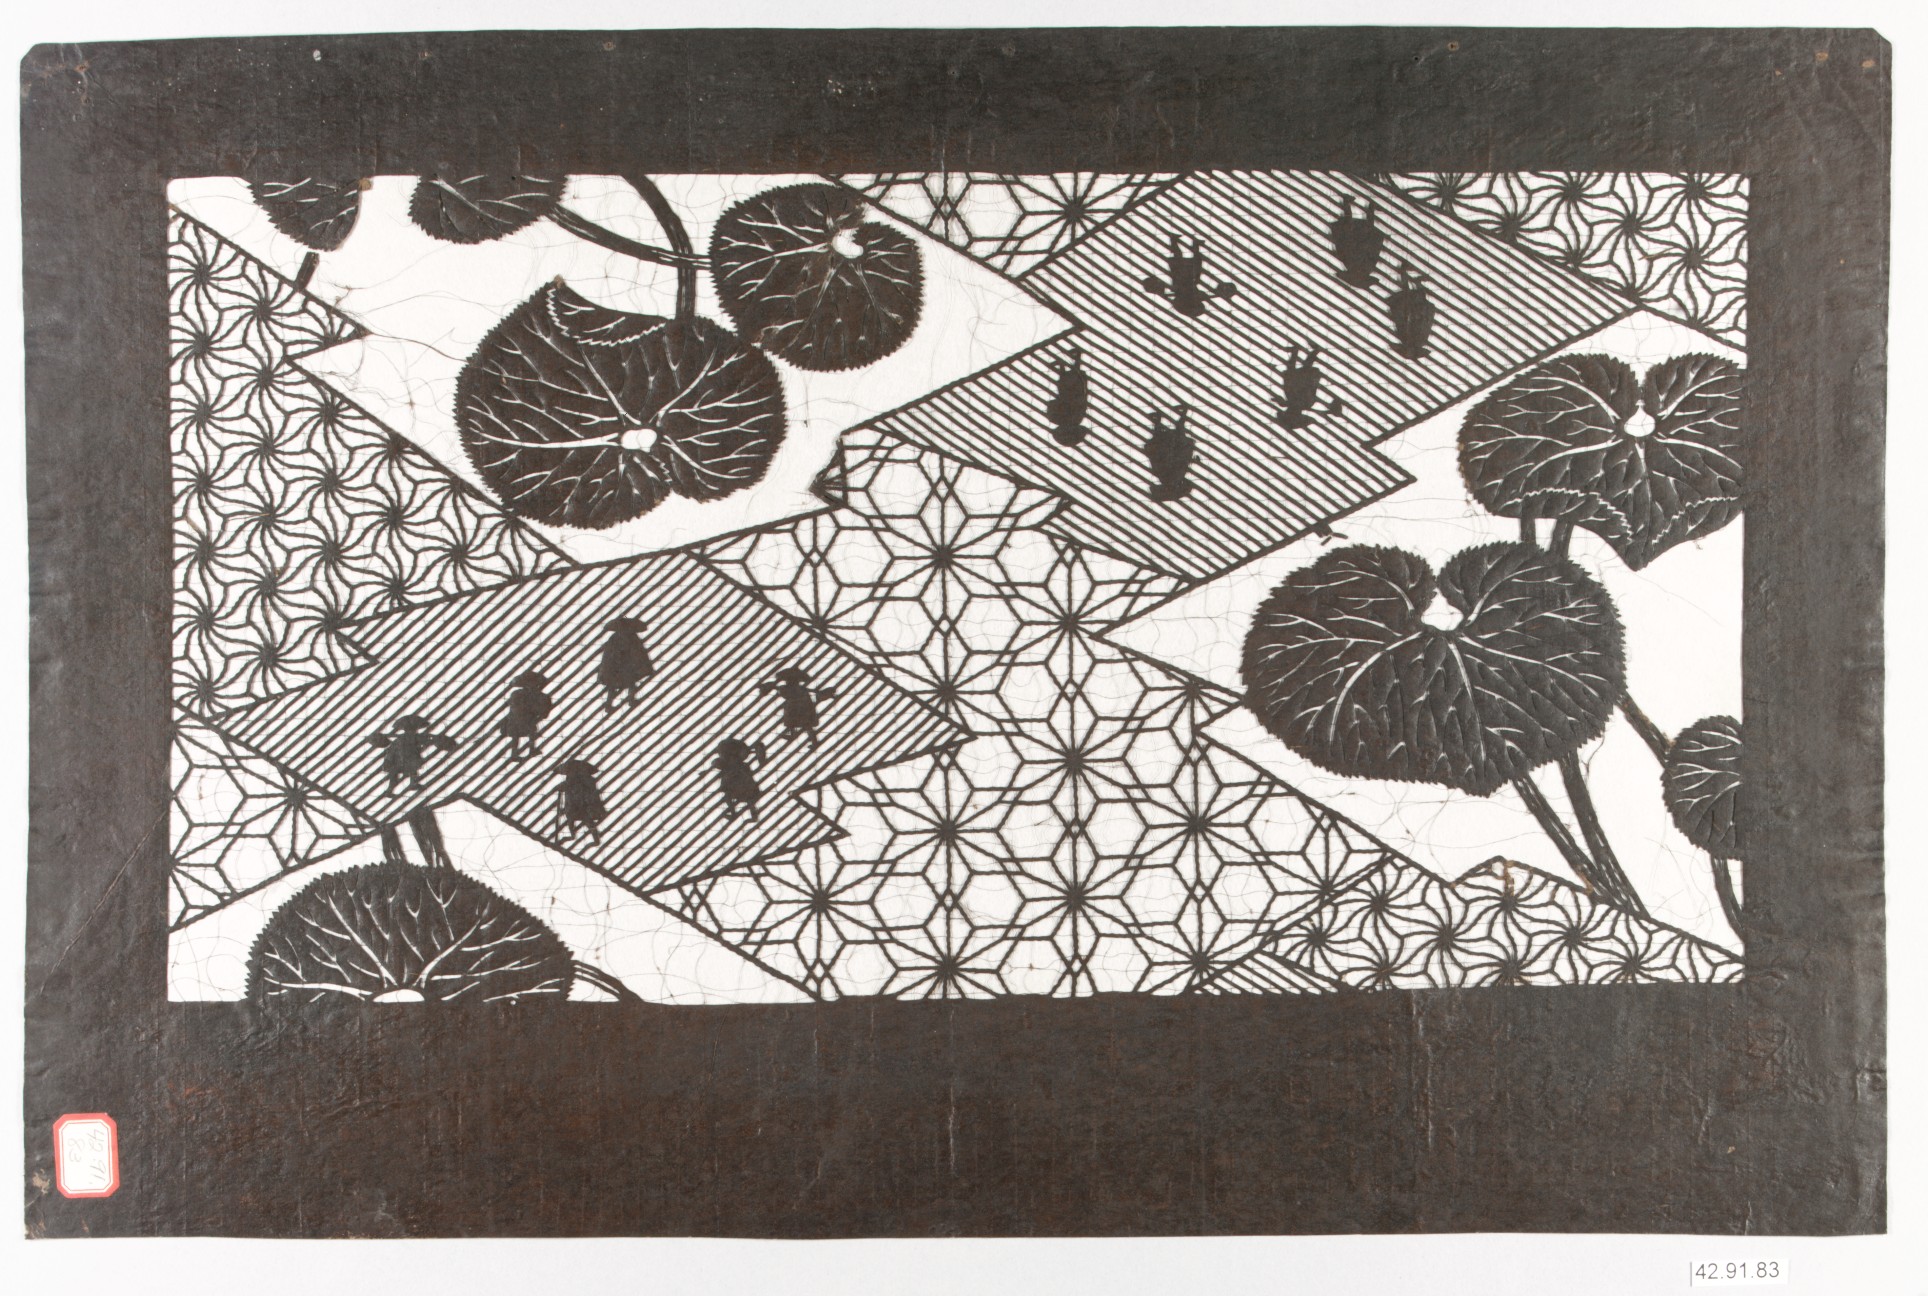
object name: stencil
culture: japanese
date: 1801-1900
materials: paper, silk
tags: human figures,leaves